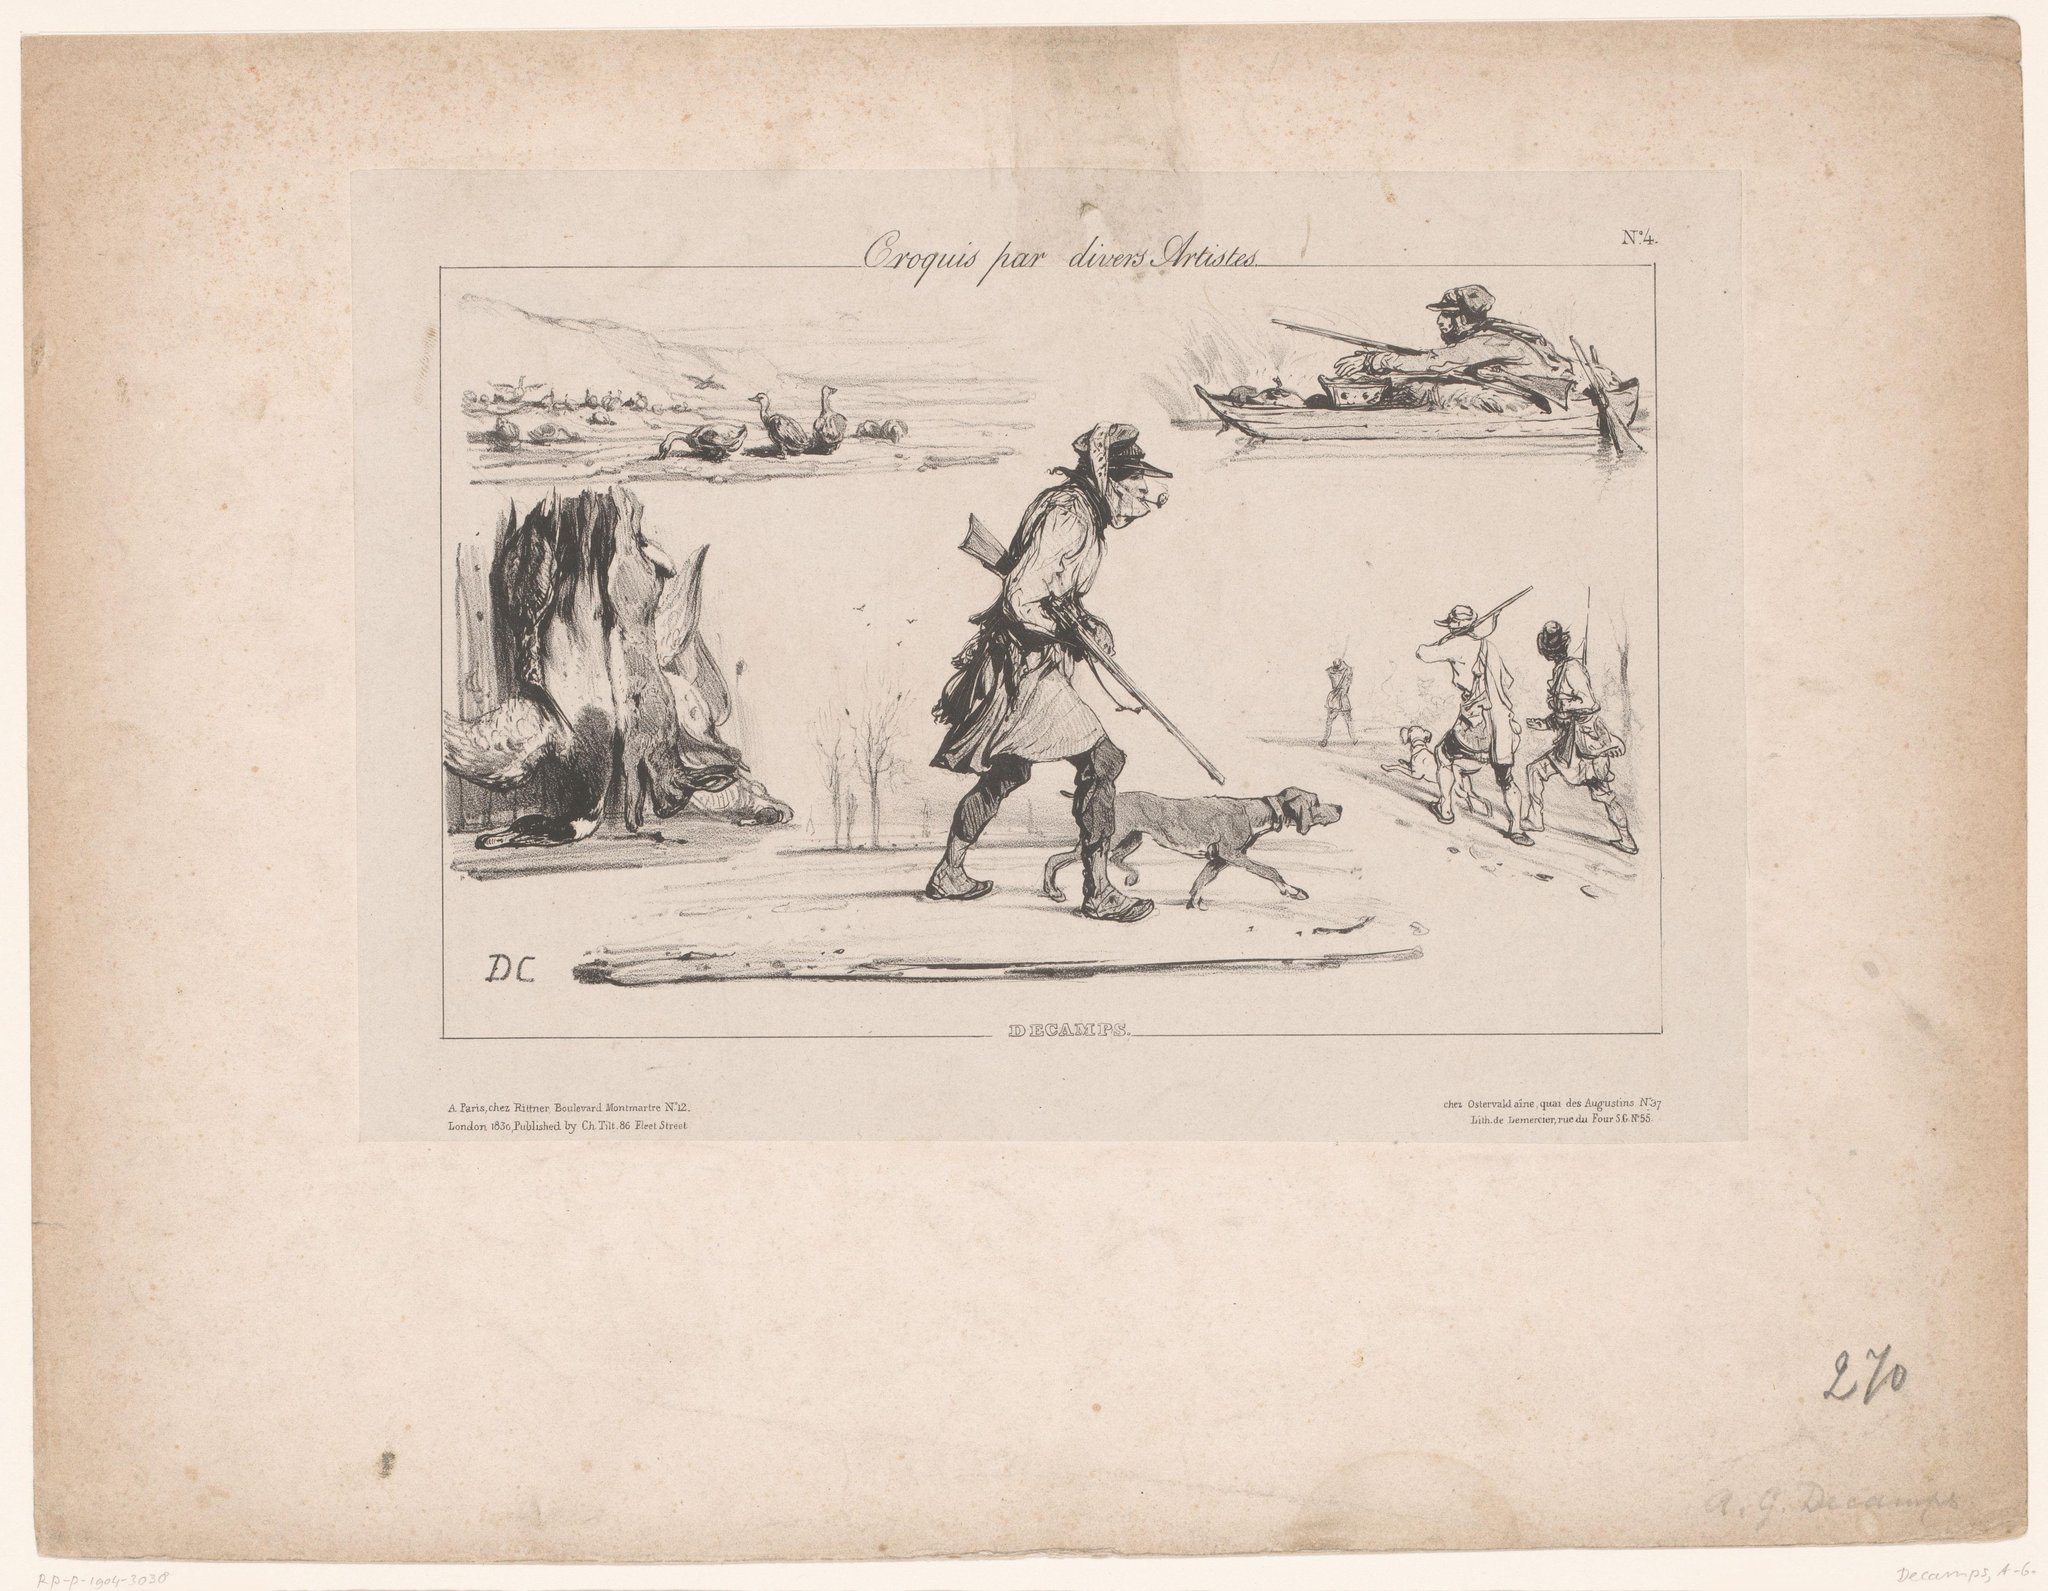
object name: print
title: Croquis par divers artistes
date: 1830-1831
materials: paper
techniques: lithograph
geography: paris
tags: hunting, chase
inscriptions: collector's mark: Lugt 2228a